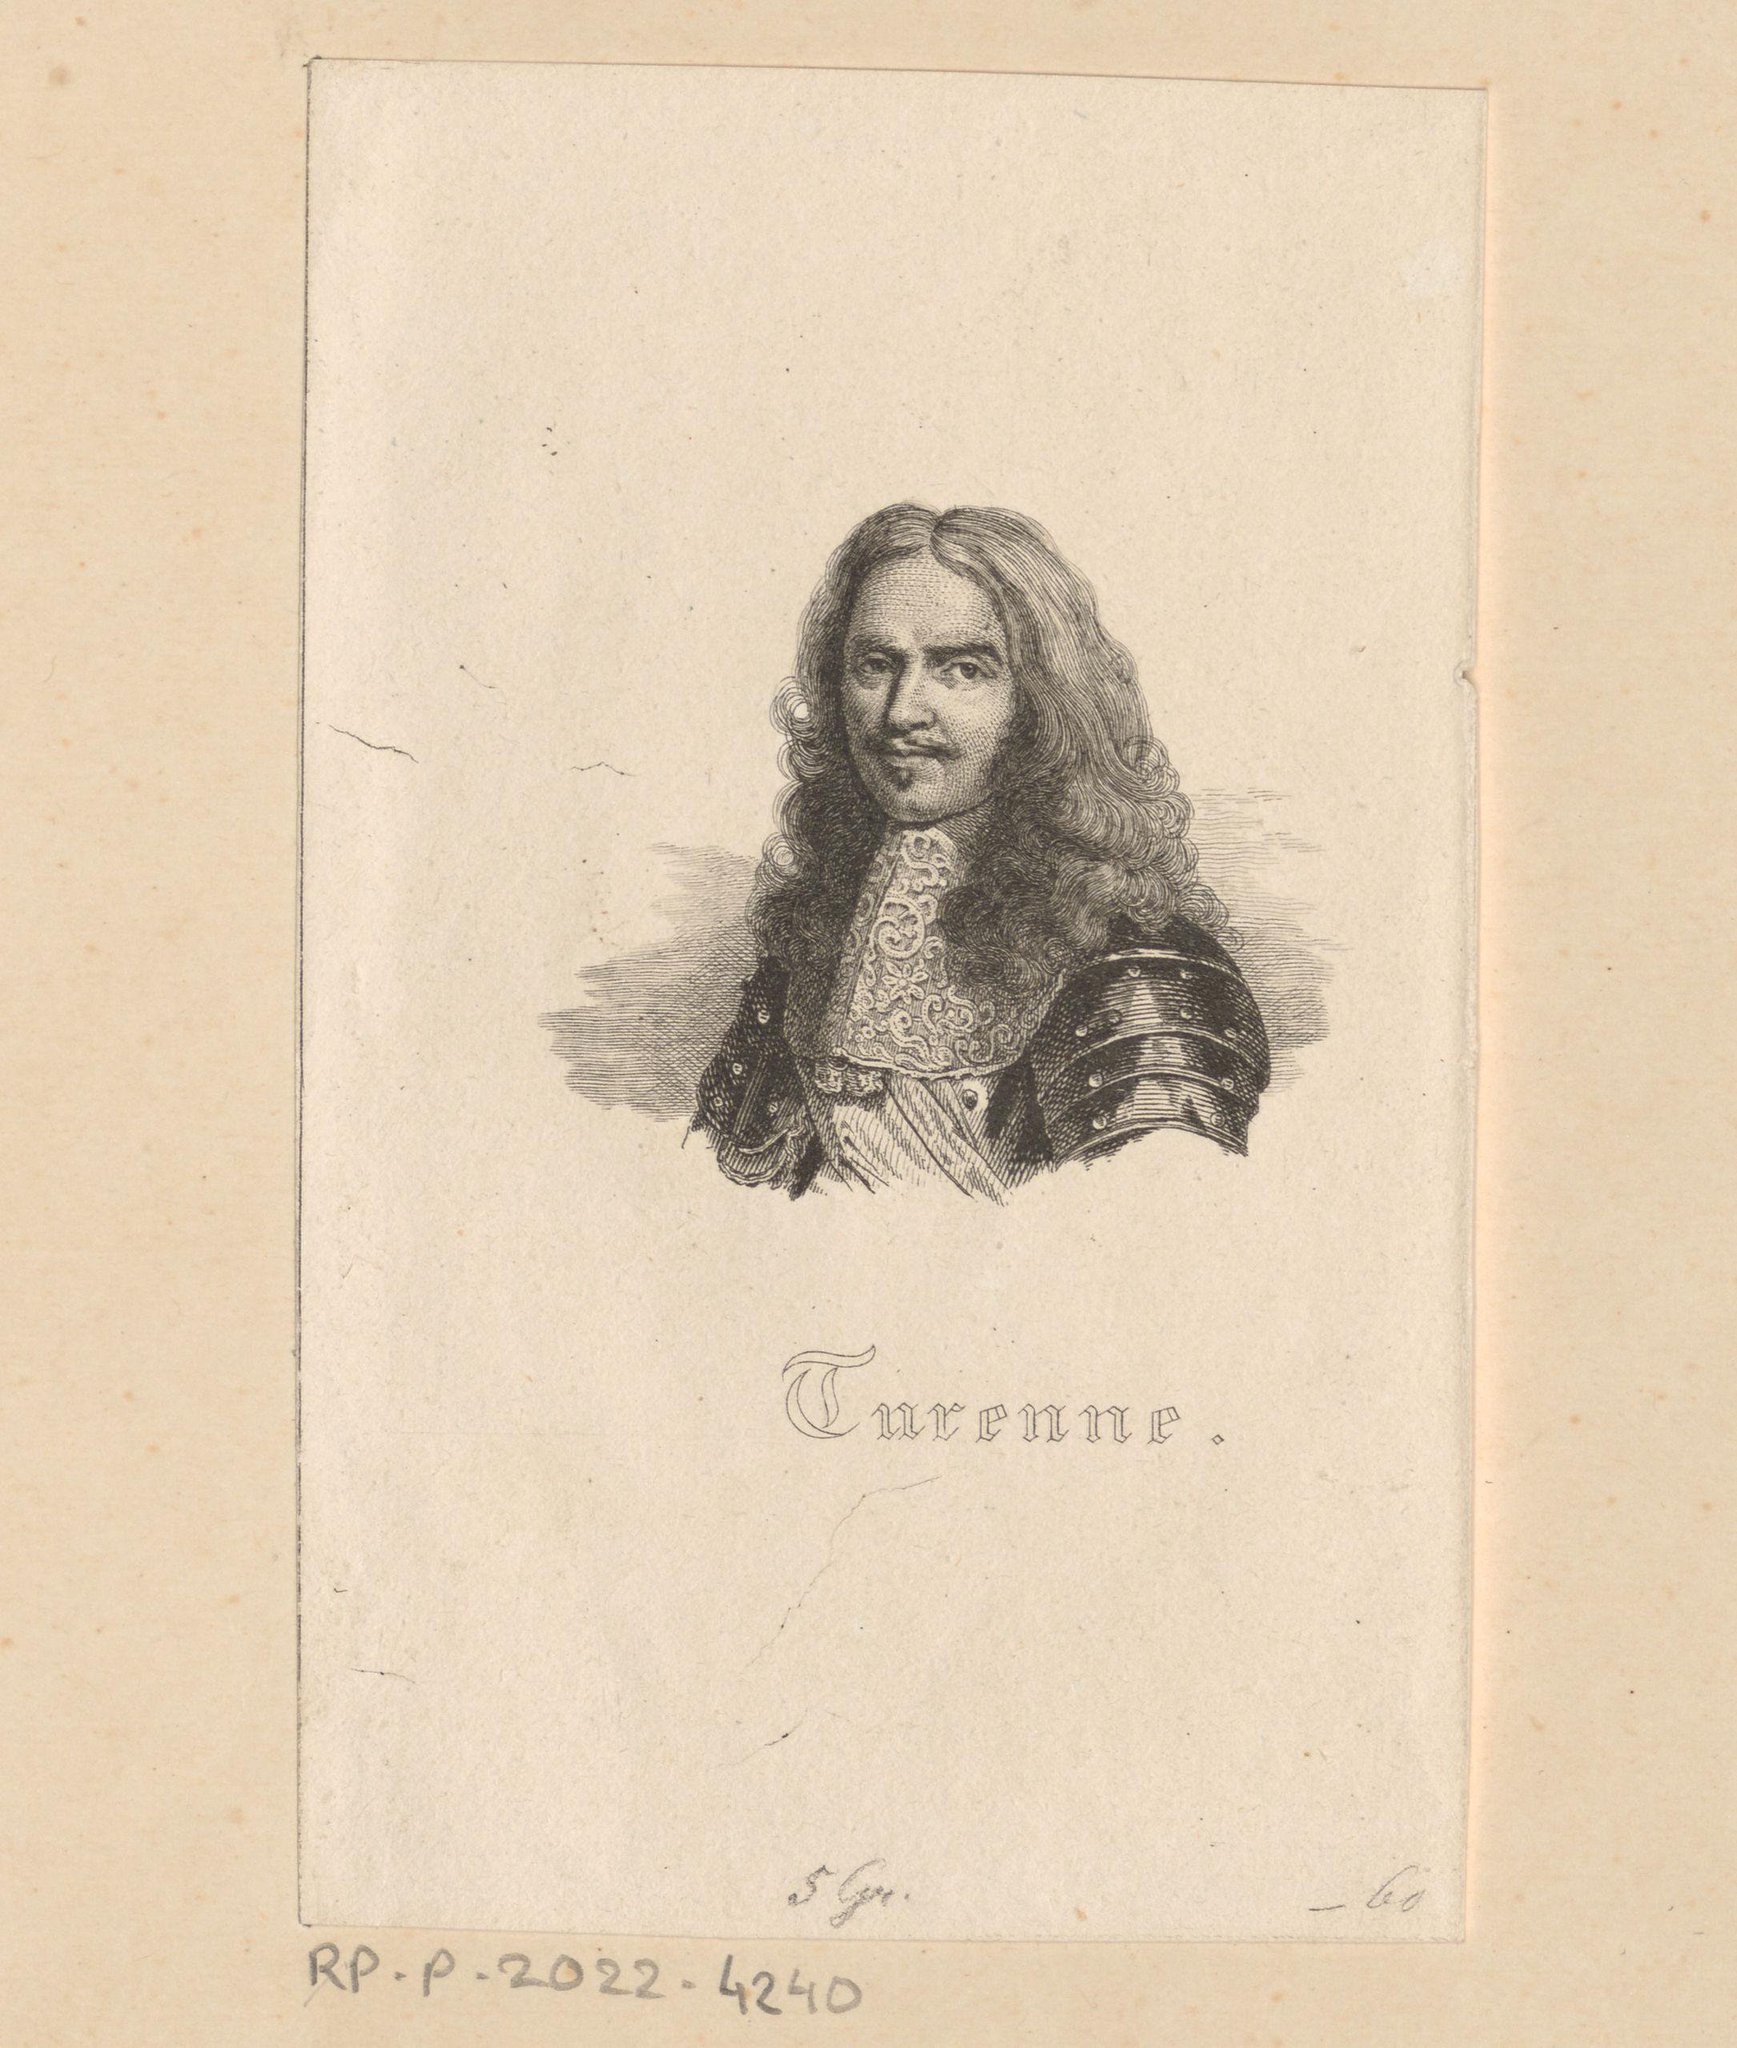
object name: print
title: Portret van Henri de La Tour d'Auvergne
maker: Anonymous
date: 1800-1875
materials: paper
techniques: etching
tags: commander-in-chief, general, marshal, armour, historical persons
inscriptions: number: ‘- 60’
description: Rechtsonder handgeschreven genummerd: 60.